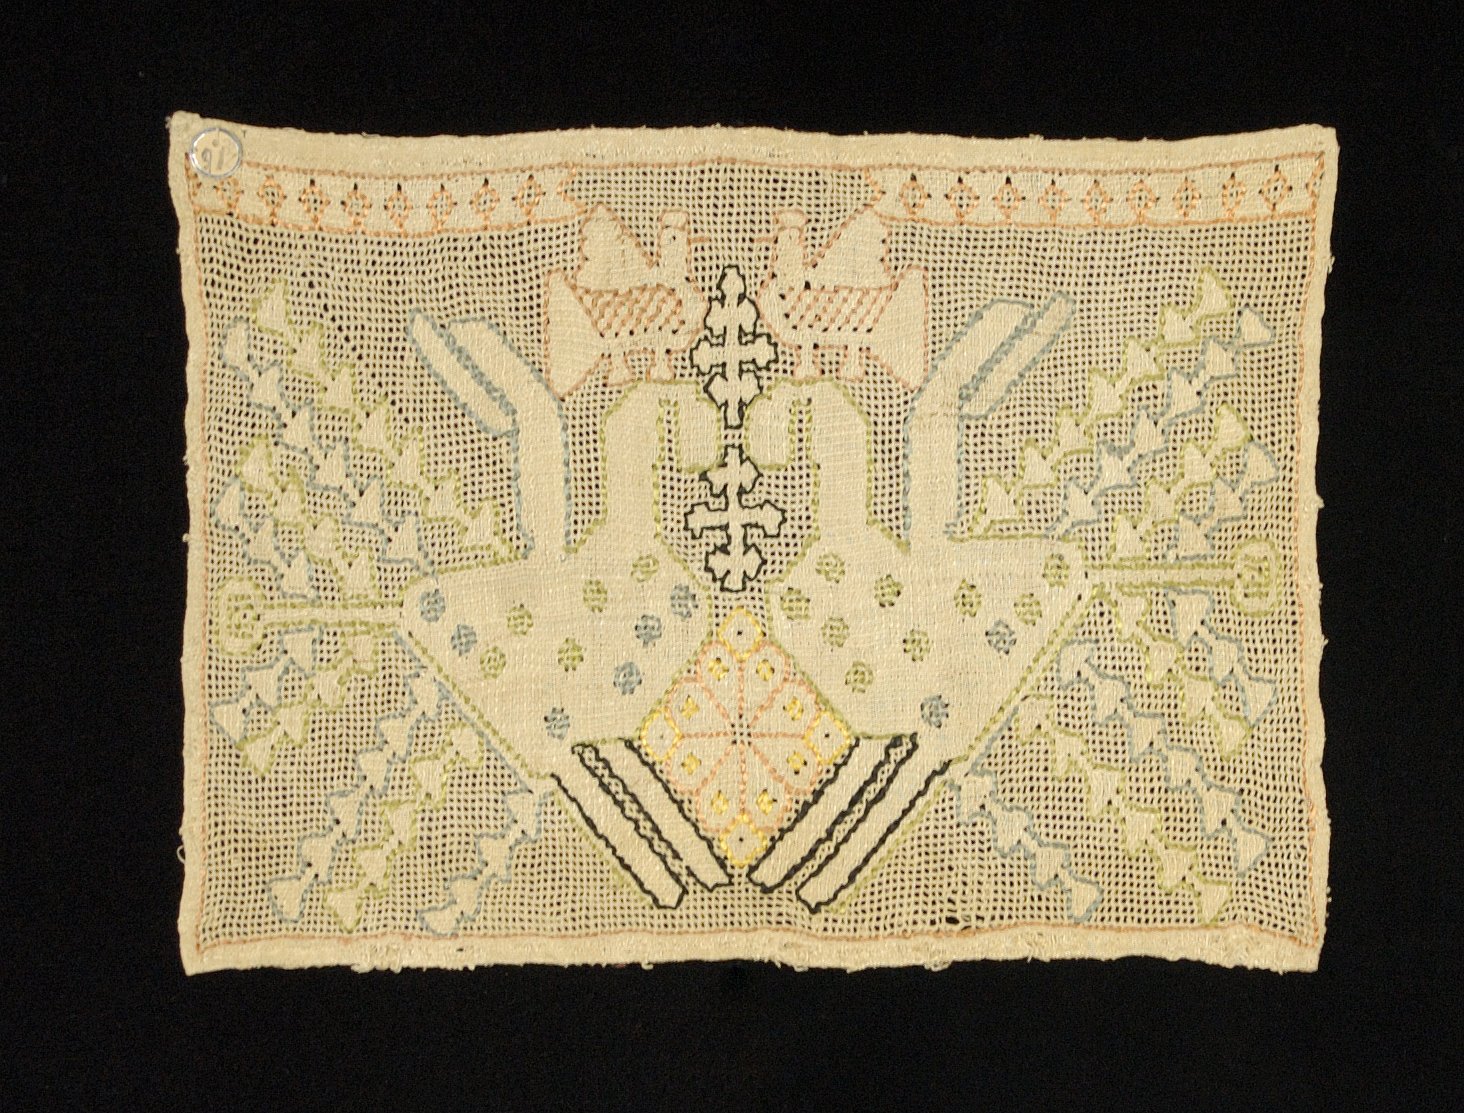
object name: border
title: Towel border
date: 1800-1850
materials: linen, silk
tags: birds